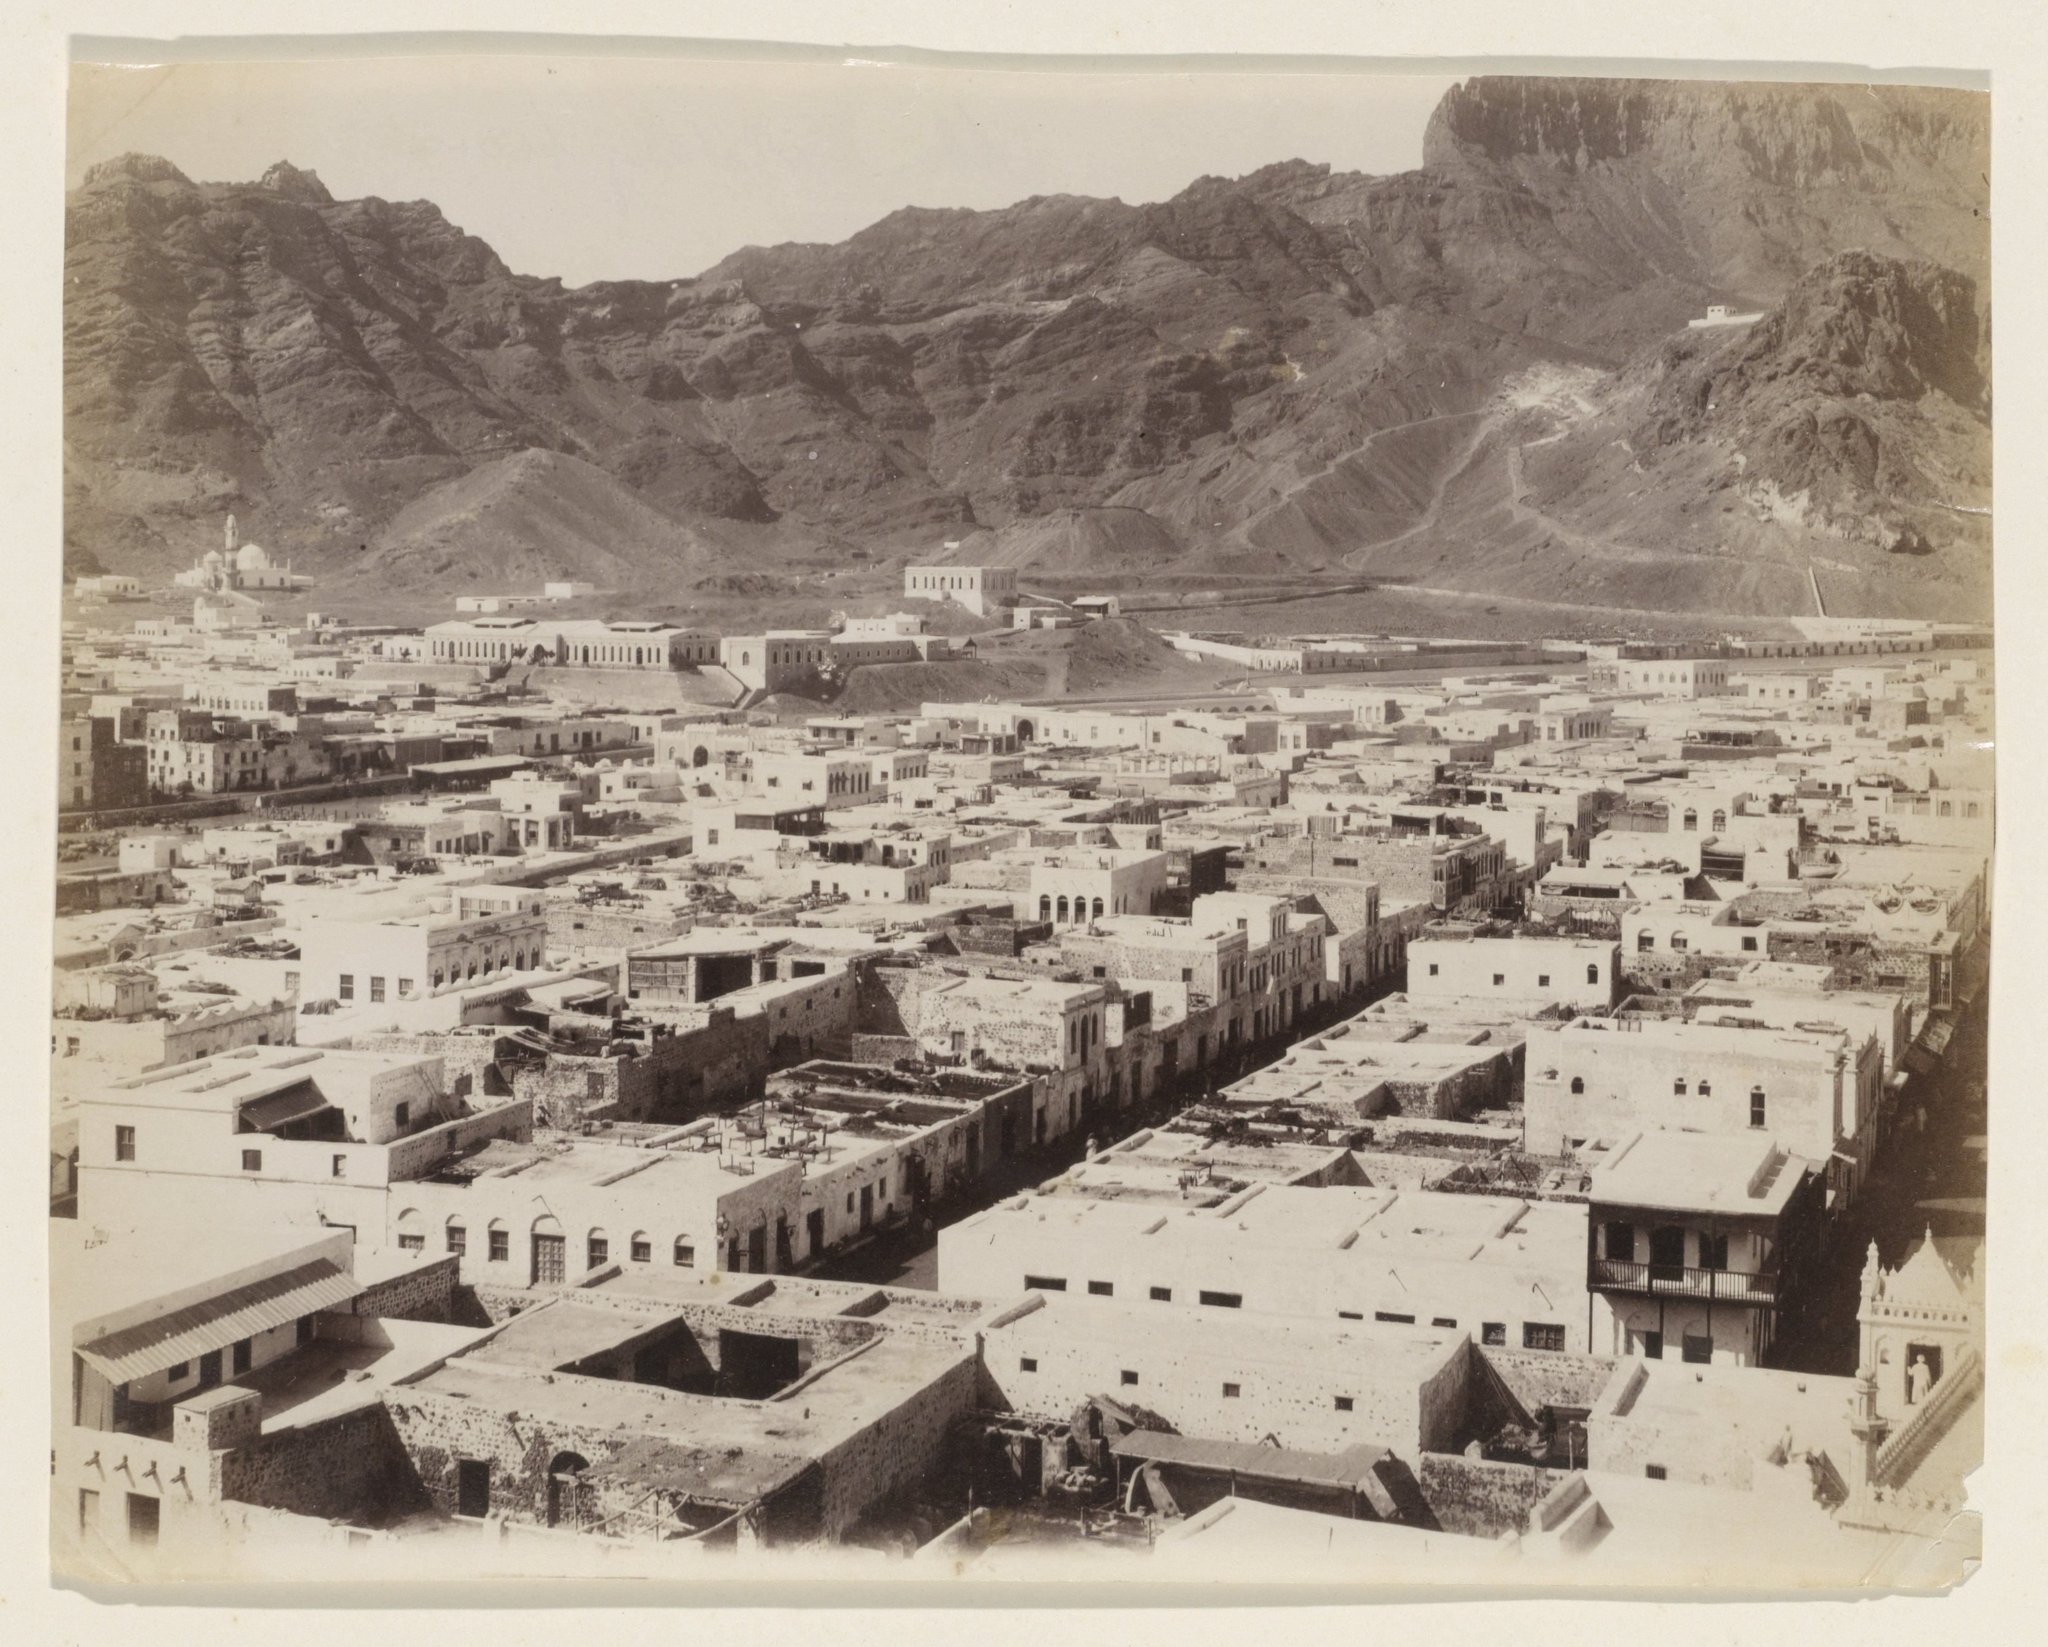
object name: photograph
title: Militaire stad aan de voet van een gebergte in Aden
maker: Anonymous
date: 1860-1900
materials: paper, photographic support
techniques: albumen print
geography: aden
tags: city-view in general; 'veduta'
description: Onderdeel van Fotoalbum van een reis door de Verenigde Staten, Honolulu, Nederlands-Indië, Aden, Zanzibar en Zuidelijk Afrika.